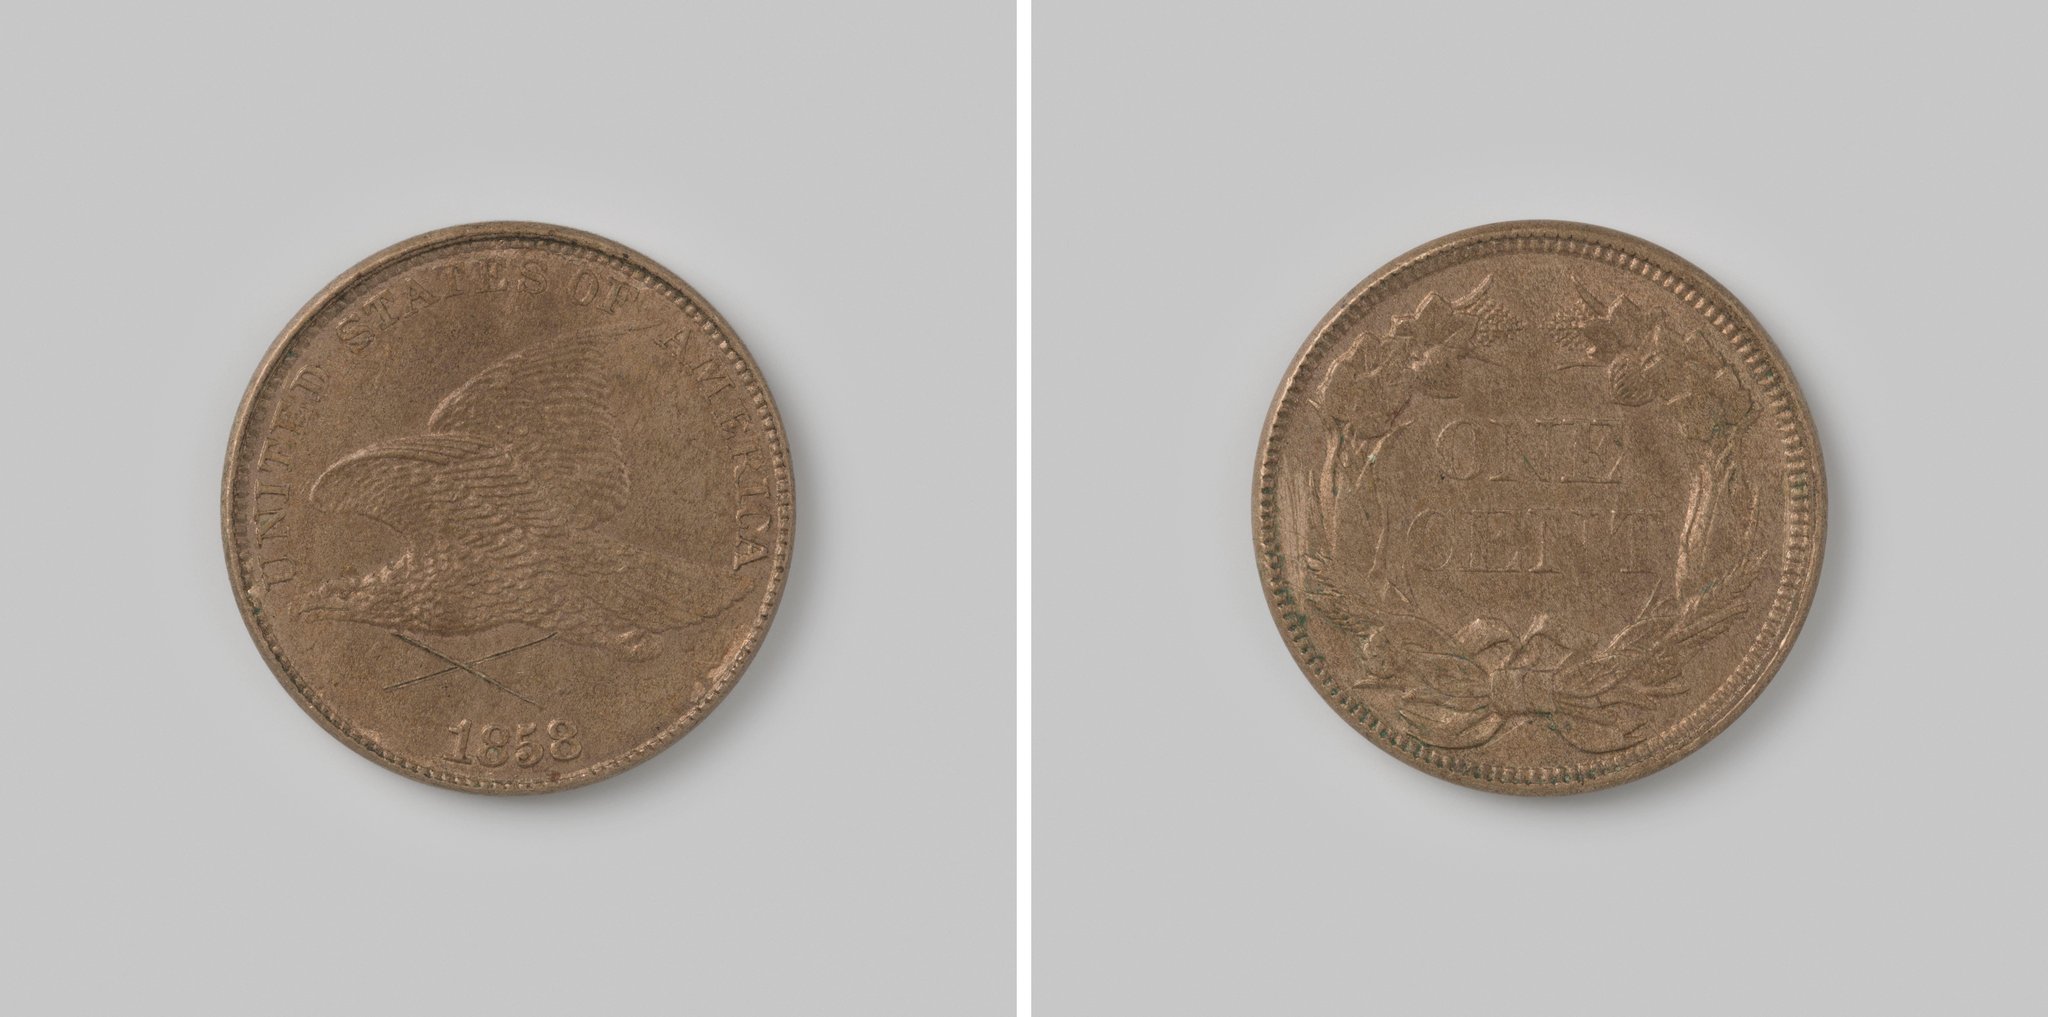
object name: coin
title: Verenigde Staten van Amerika, cent, 1858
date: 1858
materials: nickel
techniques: striking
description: Koper-nikkelen munt. Voorzijde: vliegende adelaar naar links, waaronder twee gekruiste pijlen. Jaartal onderaan. Keerzijde: tussen twee samengebonden takken waarde-aanduiding: one cent in twee regels. Gladde rand.